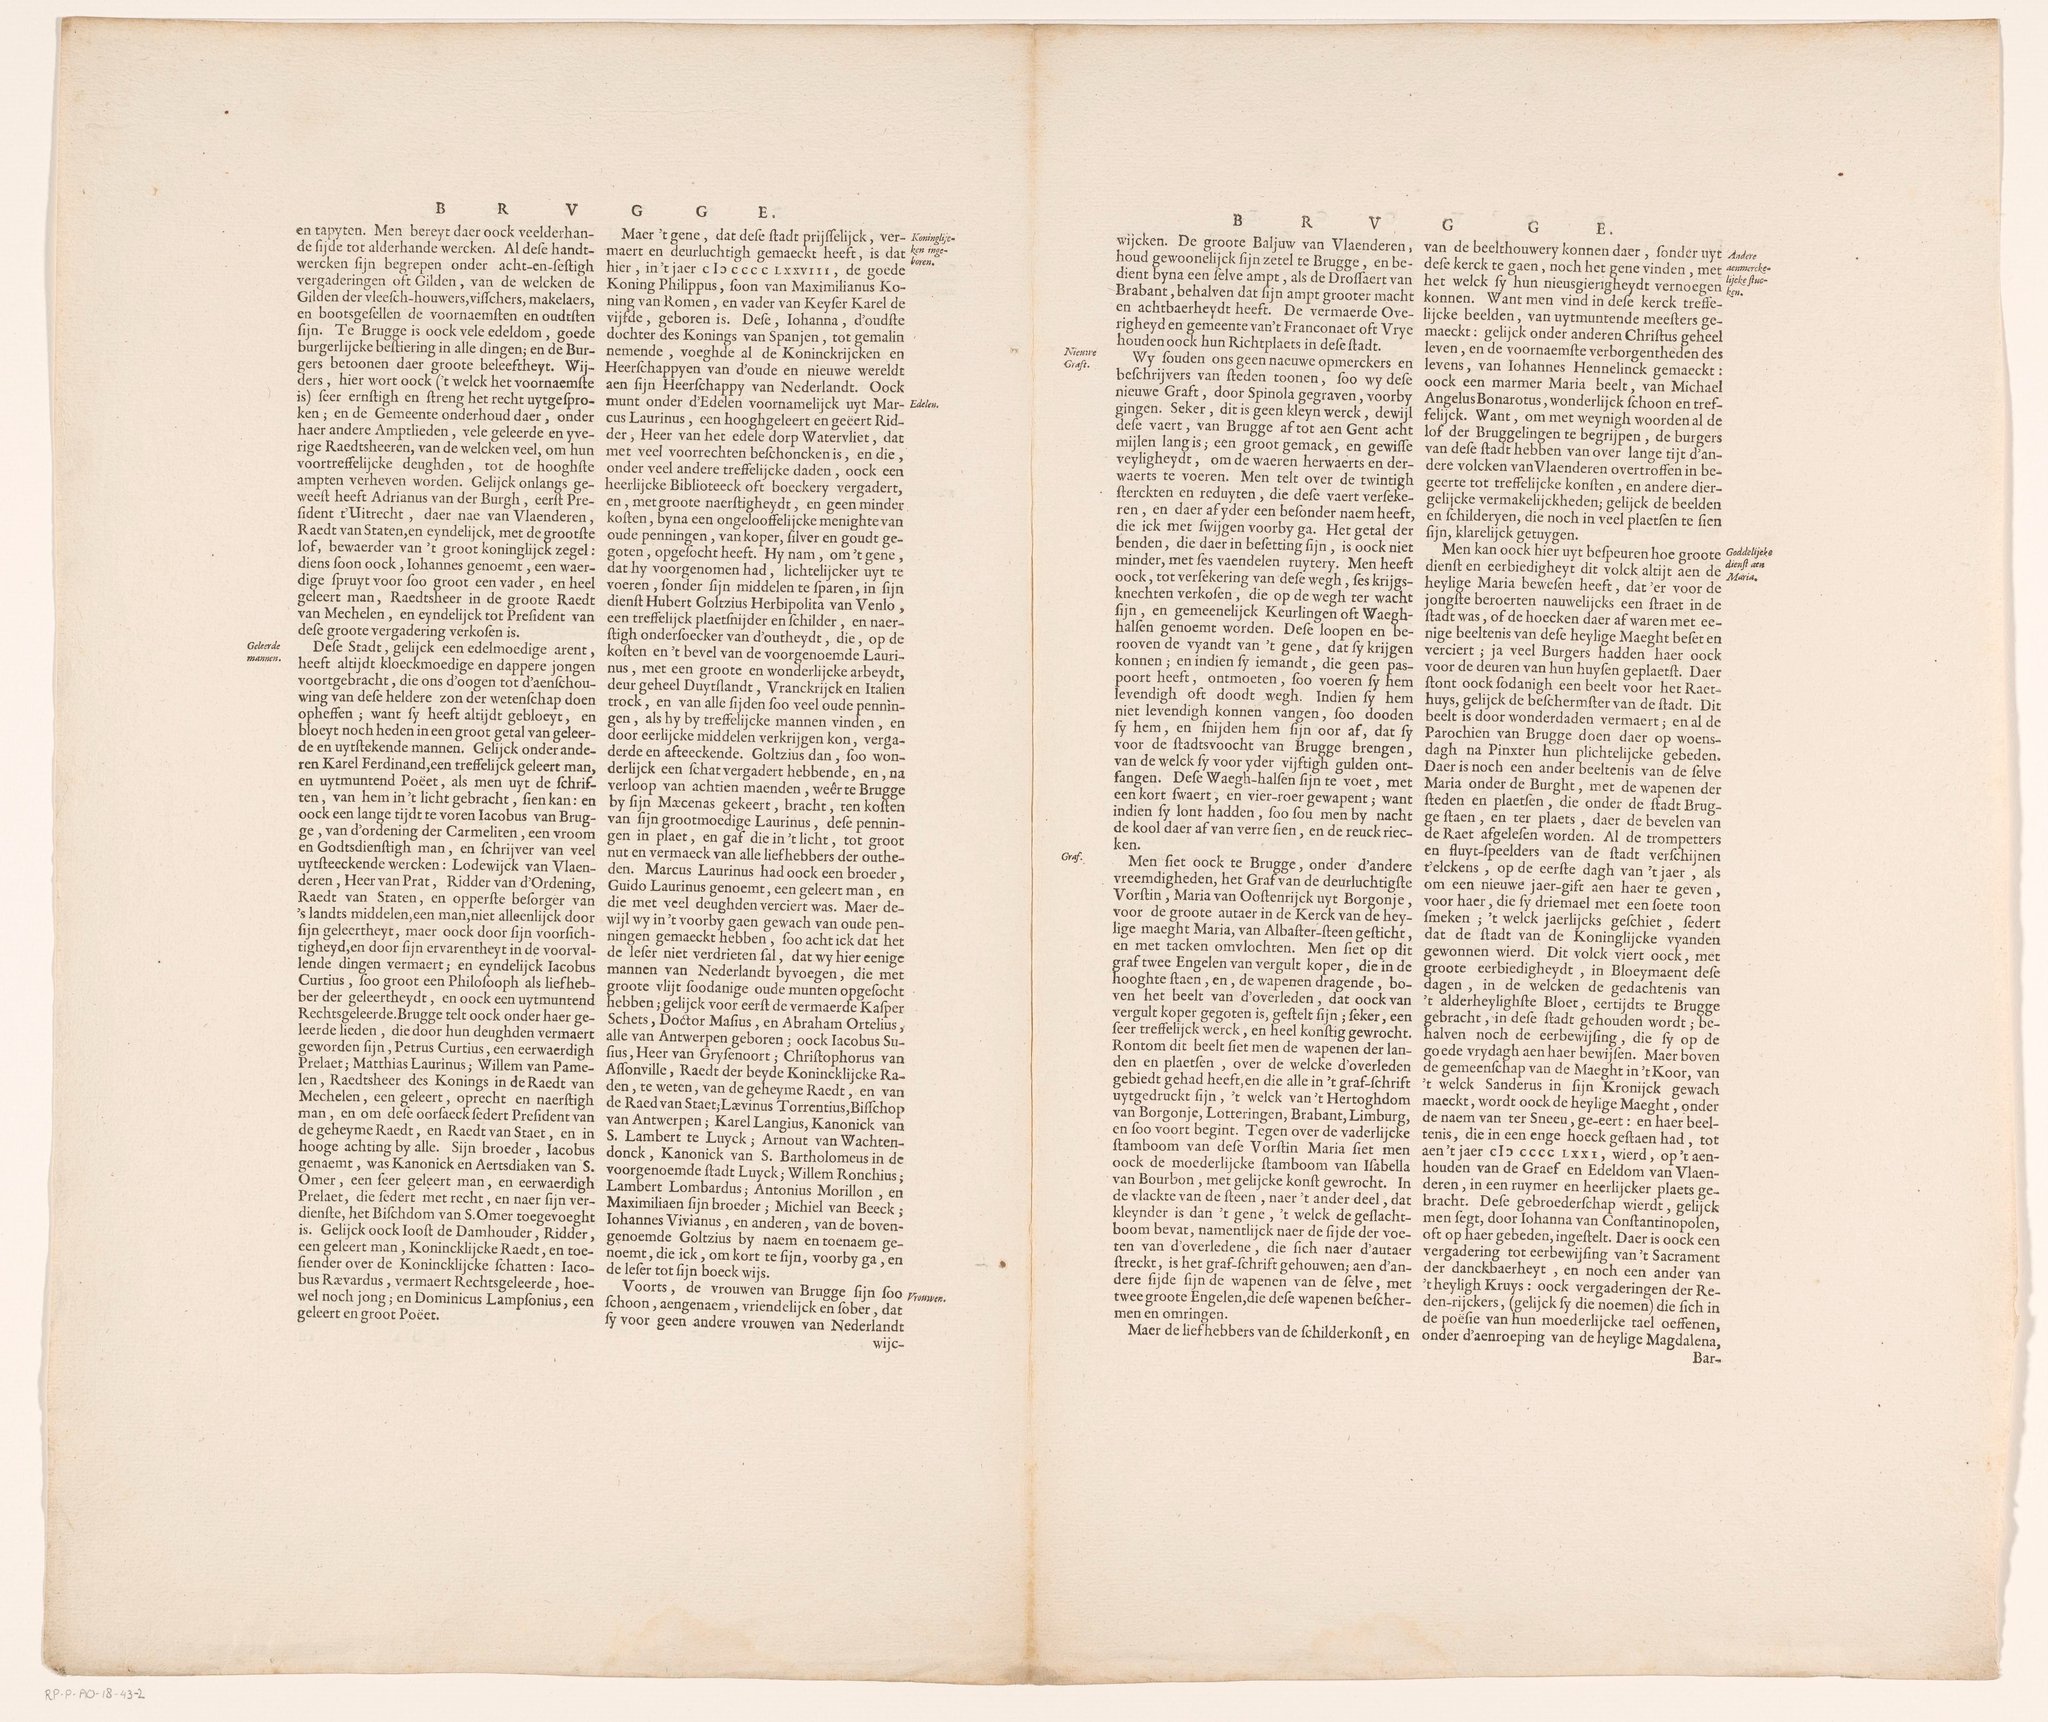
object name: text sheet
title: Deel van de beschrijving van Brugge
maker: johannes willemszoon blaeu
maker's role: printer, publisher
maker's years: 1596-1673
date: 1652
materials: paper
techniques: letterpress printing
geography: amsterdam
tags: bruges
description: Tekst gebruikt in: Blaeu, Johannes Willemszoon. Toonneel der steden van de Vereenighde Nederlanden. 2 delen. Amsterdam: Johannes Willemszoon Blaeu, 1652, dl. 2. Zie ook: RP-P-AO-18-43-1.